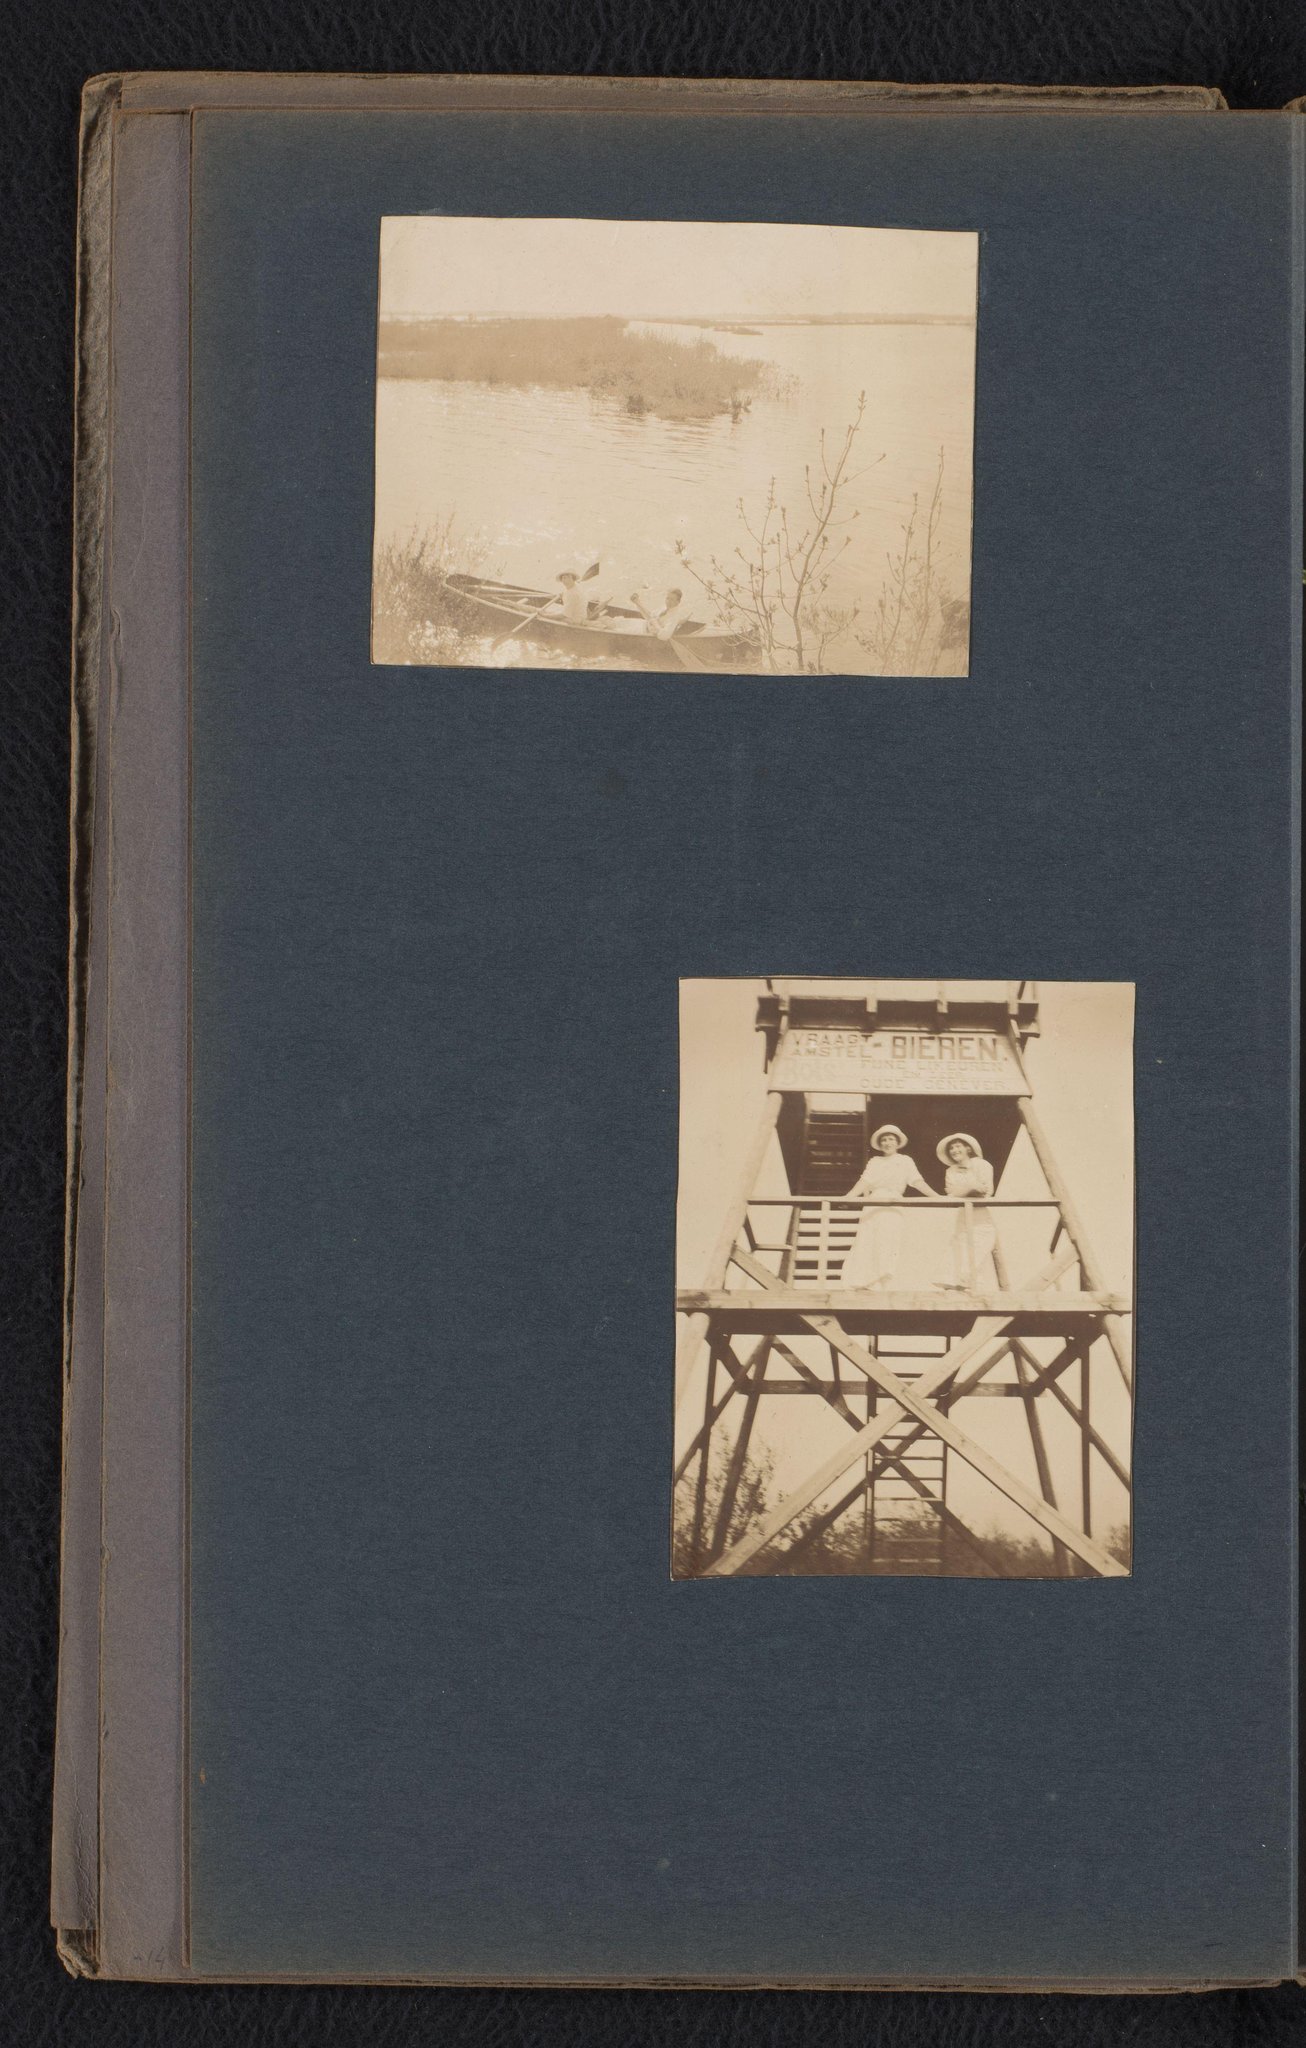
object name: photograph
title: Onbekende mensen in een roeiboot en op een uitkijktoren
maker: carolina frederika onnen (lien/loen)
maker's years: 1896-1983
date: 1912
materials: paper, cardboard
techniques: gelatin silver print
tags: rowing-boat, canoe, etc., anonymous historical person portrayed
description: Deze foto's zijn onderdeel van een album.